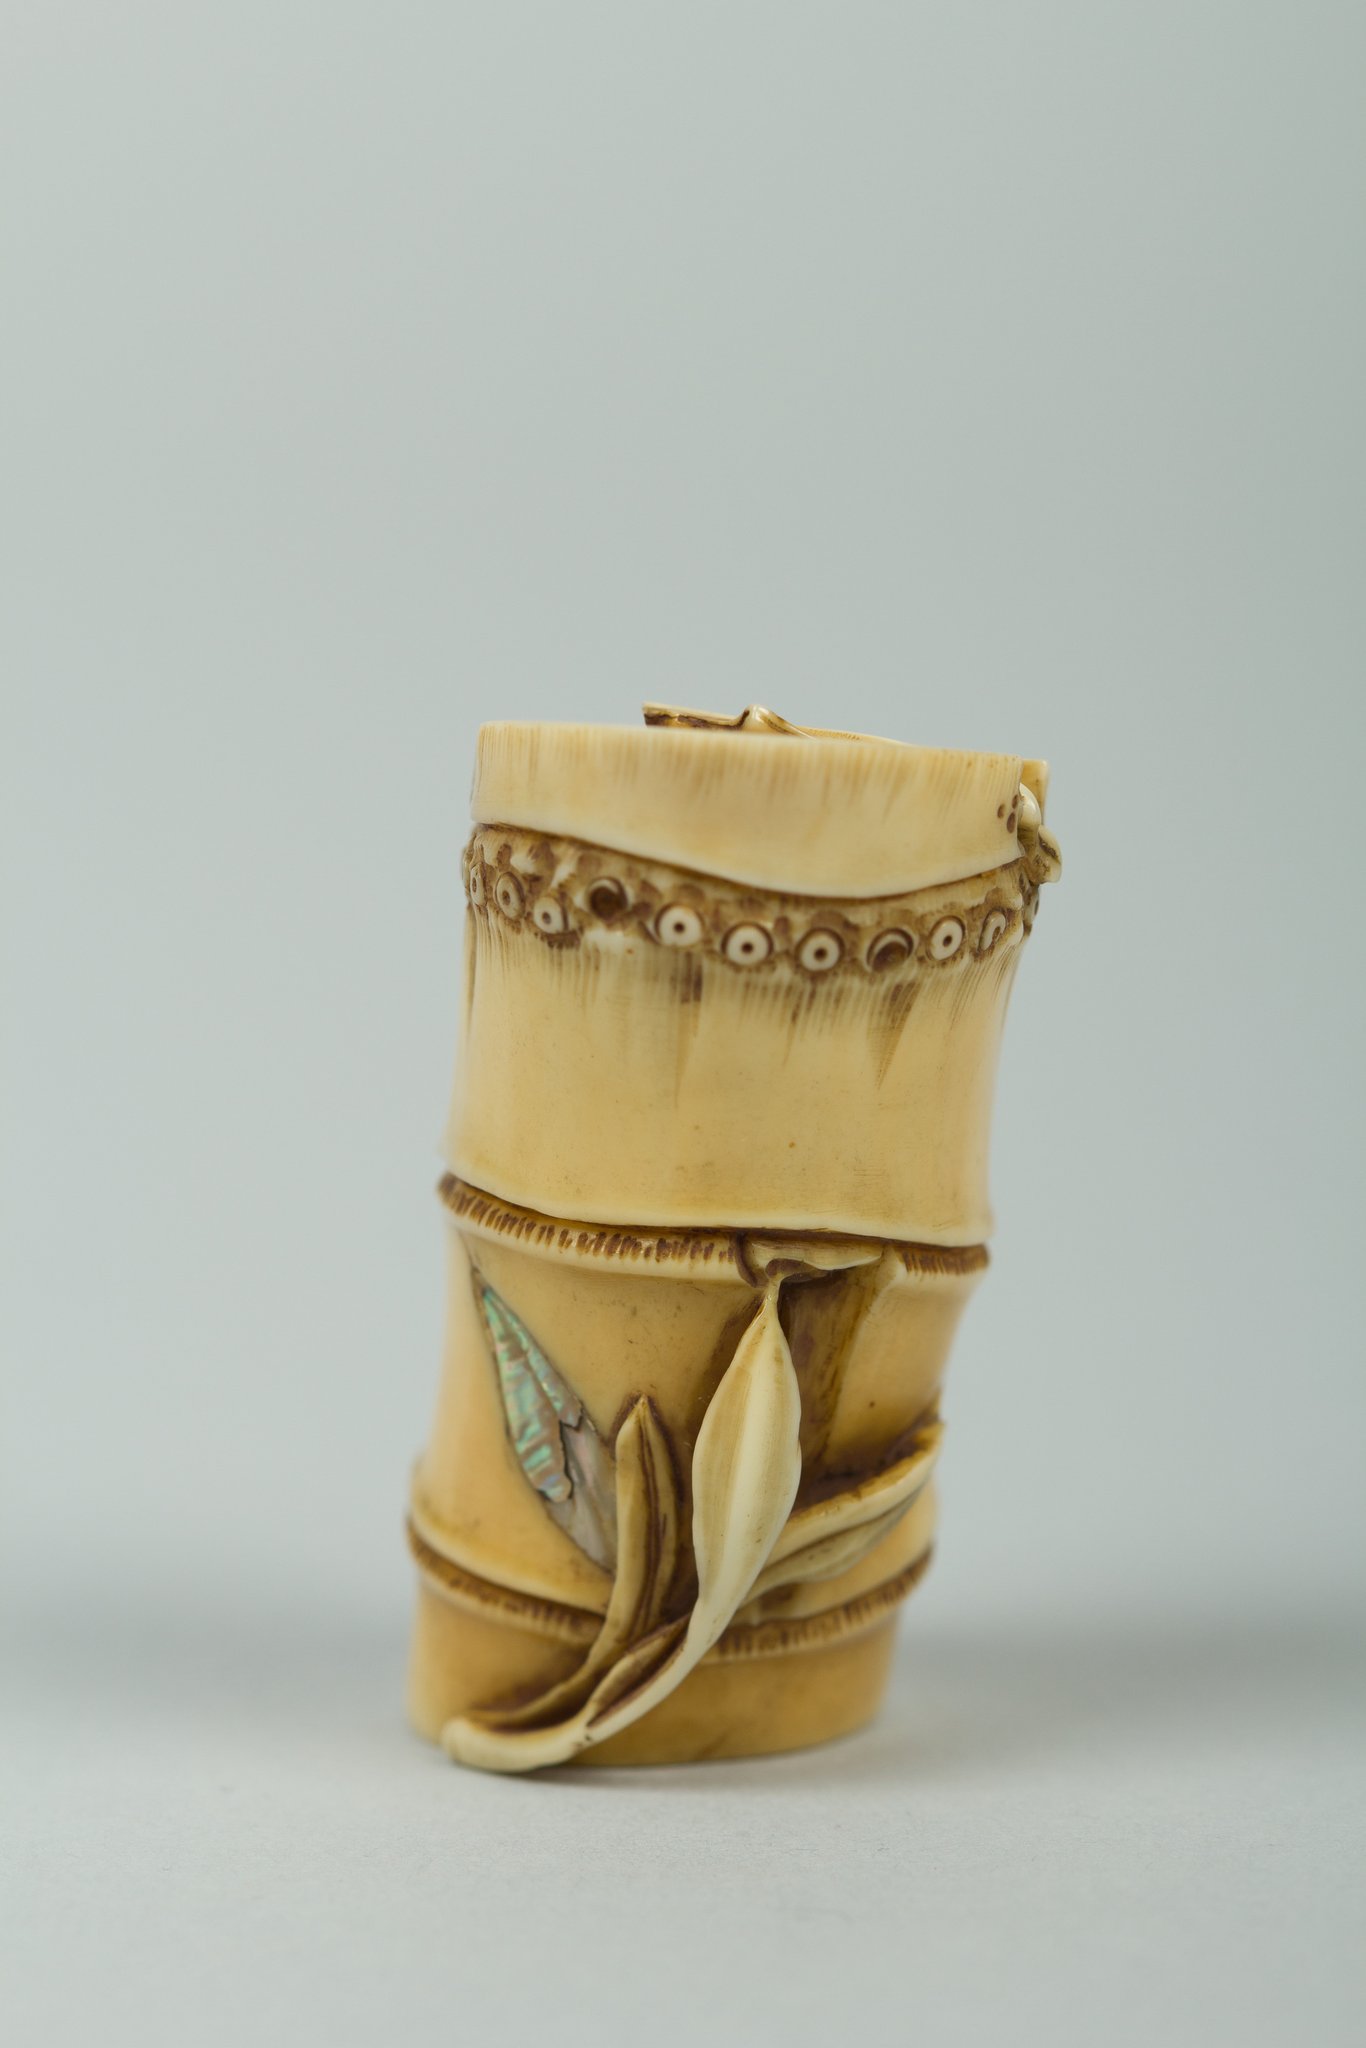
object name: netsuke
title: Netsuke of Piece of Bamboo Containing a Rat (or Bat (?)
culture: japanese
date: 1801-1900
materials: ivory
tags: bats,bamboo